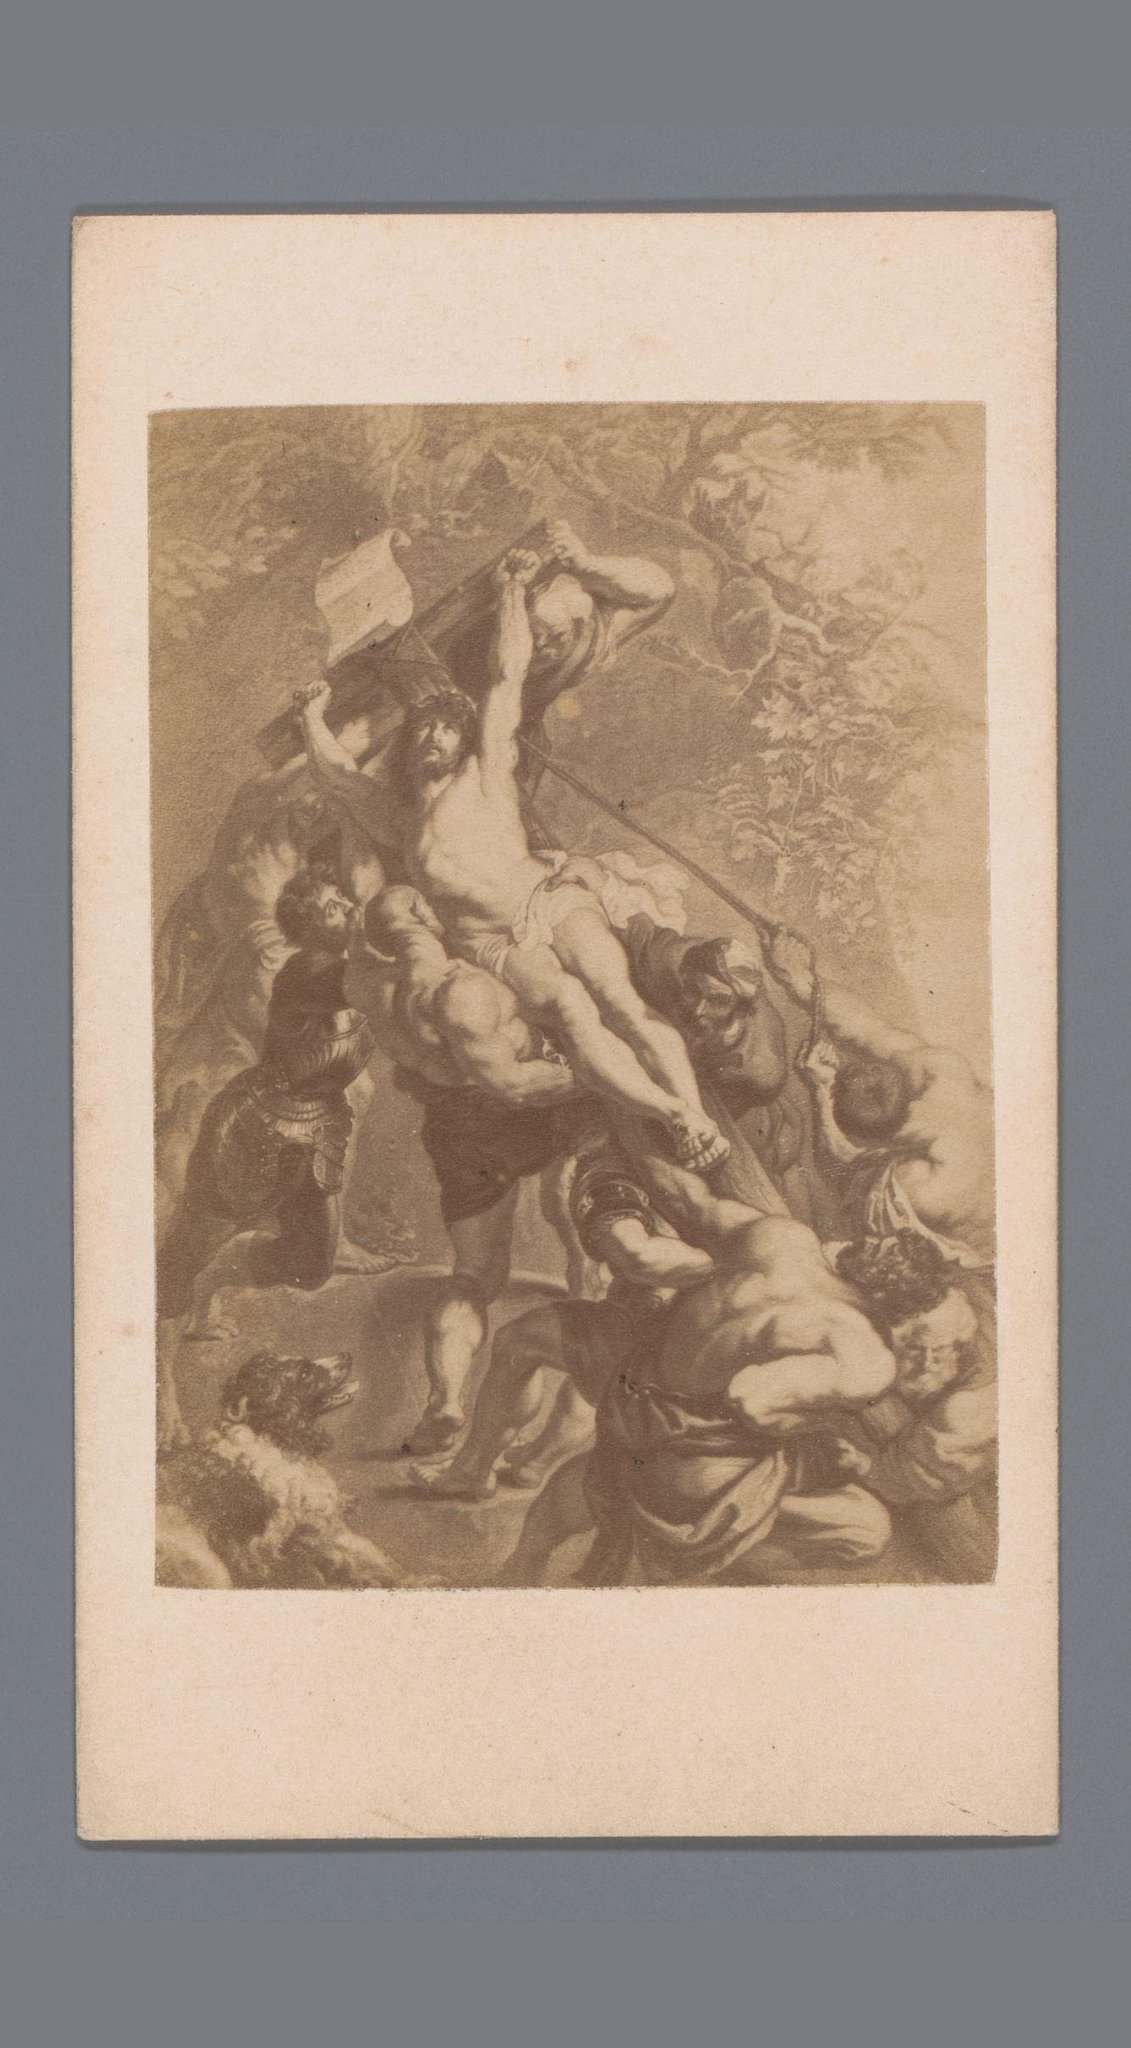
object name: photograph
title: Fotoreproductie van het schilderij De kruisoprichting van Rubens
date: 1858-1866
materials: cardboard, paper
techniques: albumen print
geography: antwerp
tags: christ is nailed to the erected cross, christ still alive ~ particularities of crucifixion scenes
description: Het originele schilderij, een altaarstuk, bevindt zich in de Onze-Lieve-Vrouwenkathedraal in Antwerpen.